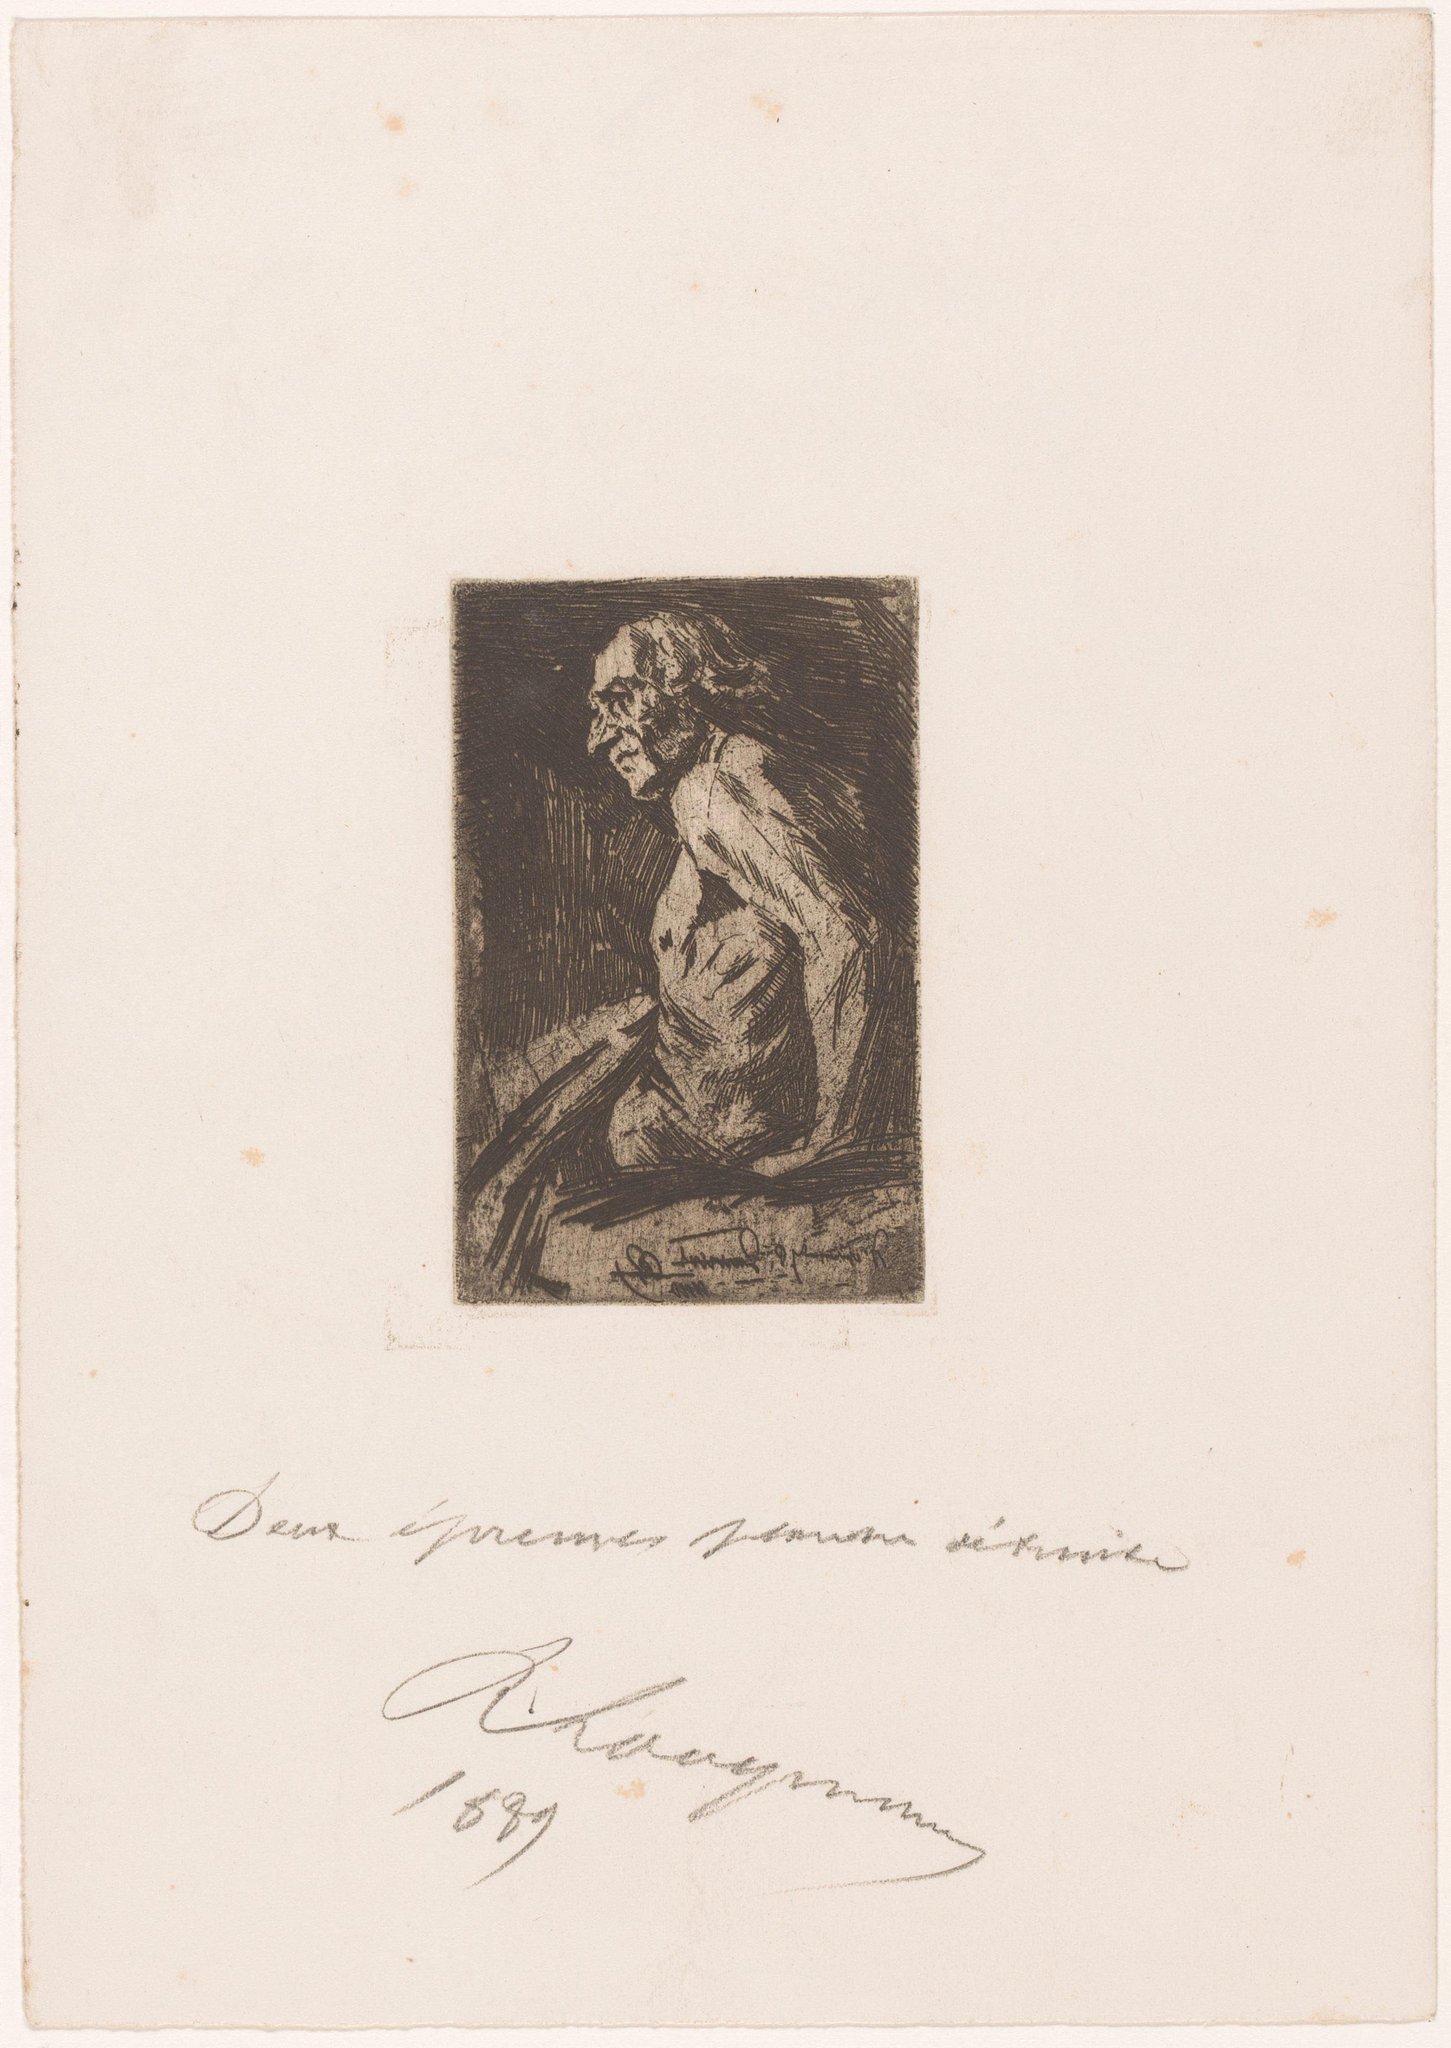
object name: print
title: Man komt overeind in bed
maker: romain looymans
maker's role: print maker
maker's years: 1864-1914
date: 1889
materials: paper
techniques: drypoint, etching, intaglio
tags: getting up from bed, man (showing himself) undressed, quasi-nude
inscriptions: annotation: ‘Deux épreuves planche détruite.’, collector's mark: Lugt 2228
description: Onderin de plaat staat een opschrift in spiegelbeeld. Hoewel het opschrift moeilijk leesbaar is, staat hier mogelijk: "2 epreuves P. Laurent".